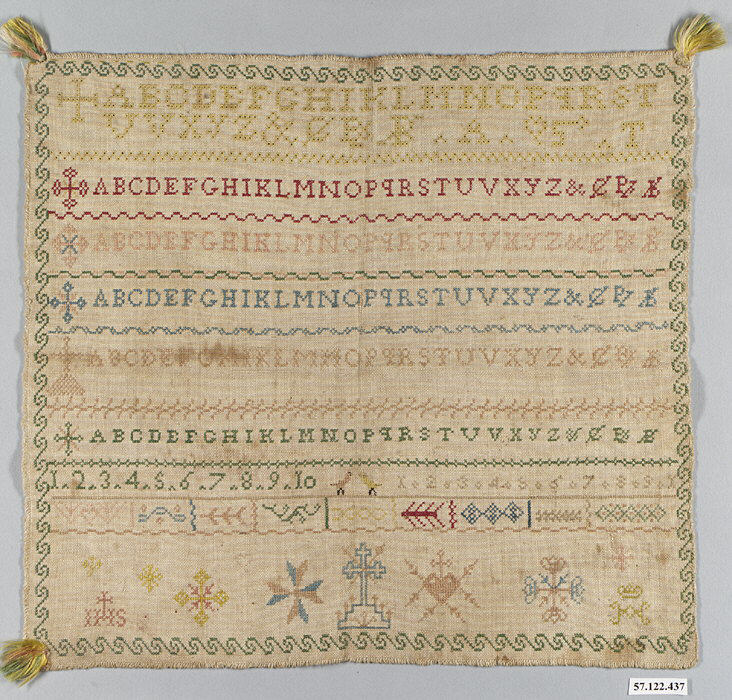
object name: sampler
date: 1801-1900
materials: linen, silk